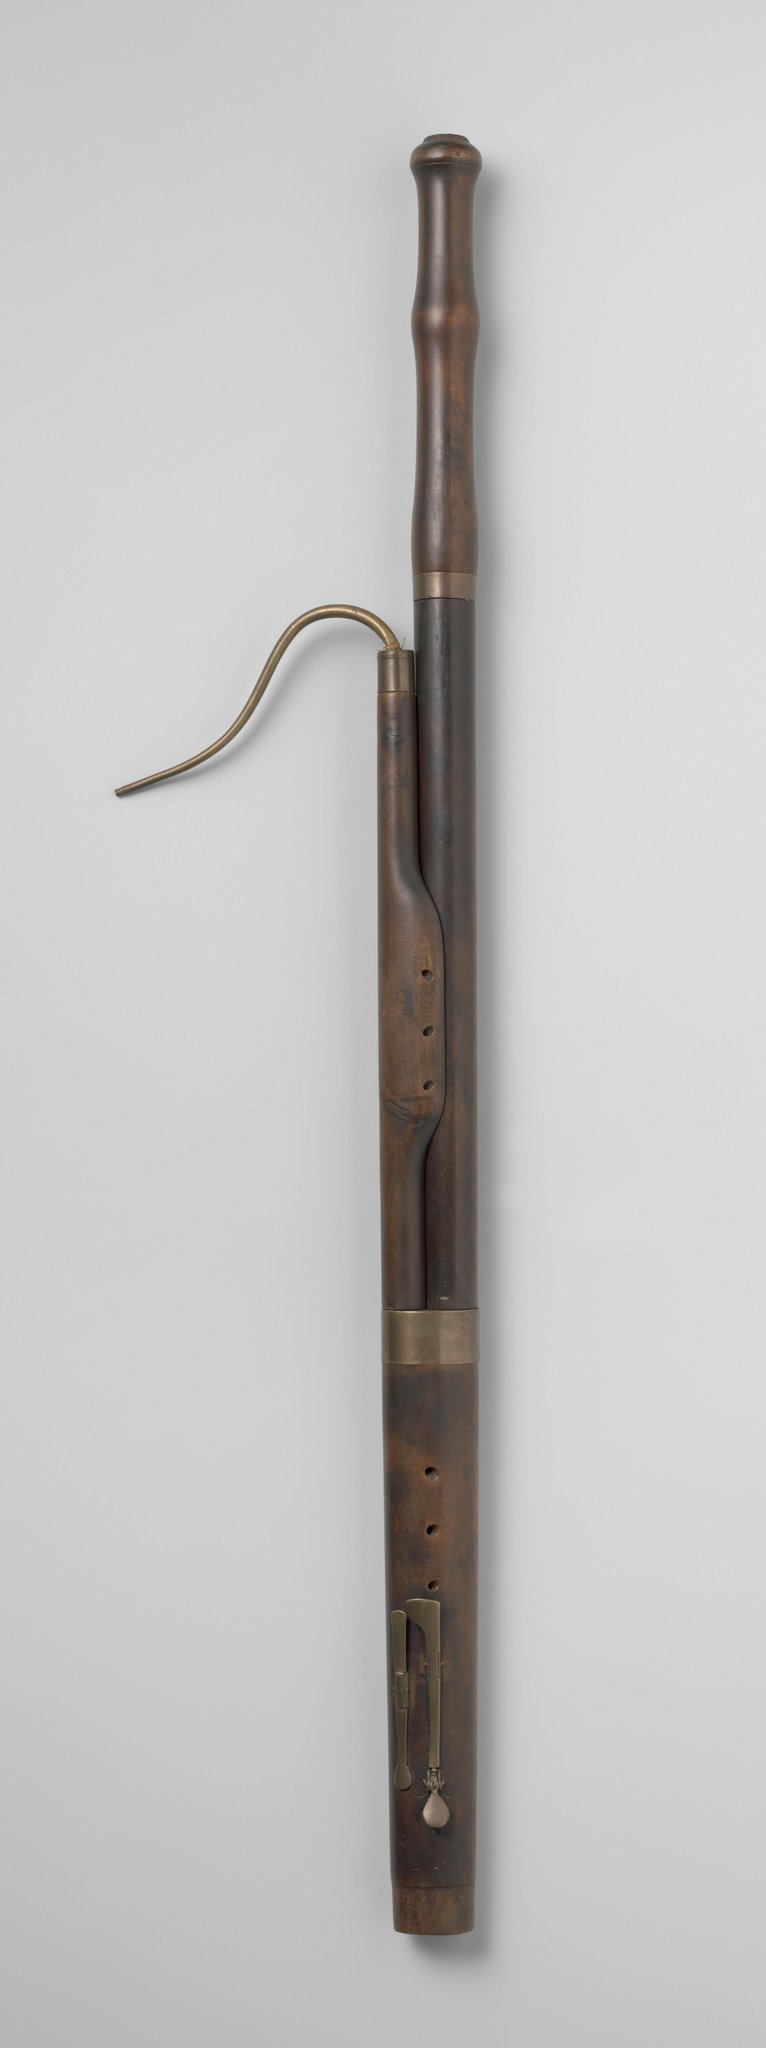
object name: musical instrument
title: Bassoon butt joint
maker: johannes van de knikker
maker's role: musical instrument maker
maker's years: 1731-1815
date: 1780-1800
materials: copper, wood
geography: tilburg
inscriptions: stamp: ‘IVD/ KNIKKER/ TILBORGH’, stamp: ‘IVD/ KNIKKER’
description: Fagot van esdoornhout met vier koperen kleppen en met acht onbedekte gaten. Koperen monstuk en koperen ringen waarvan de onderste ontbreekt.